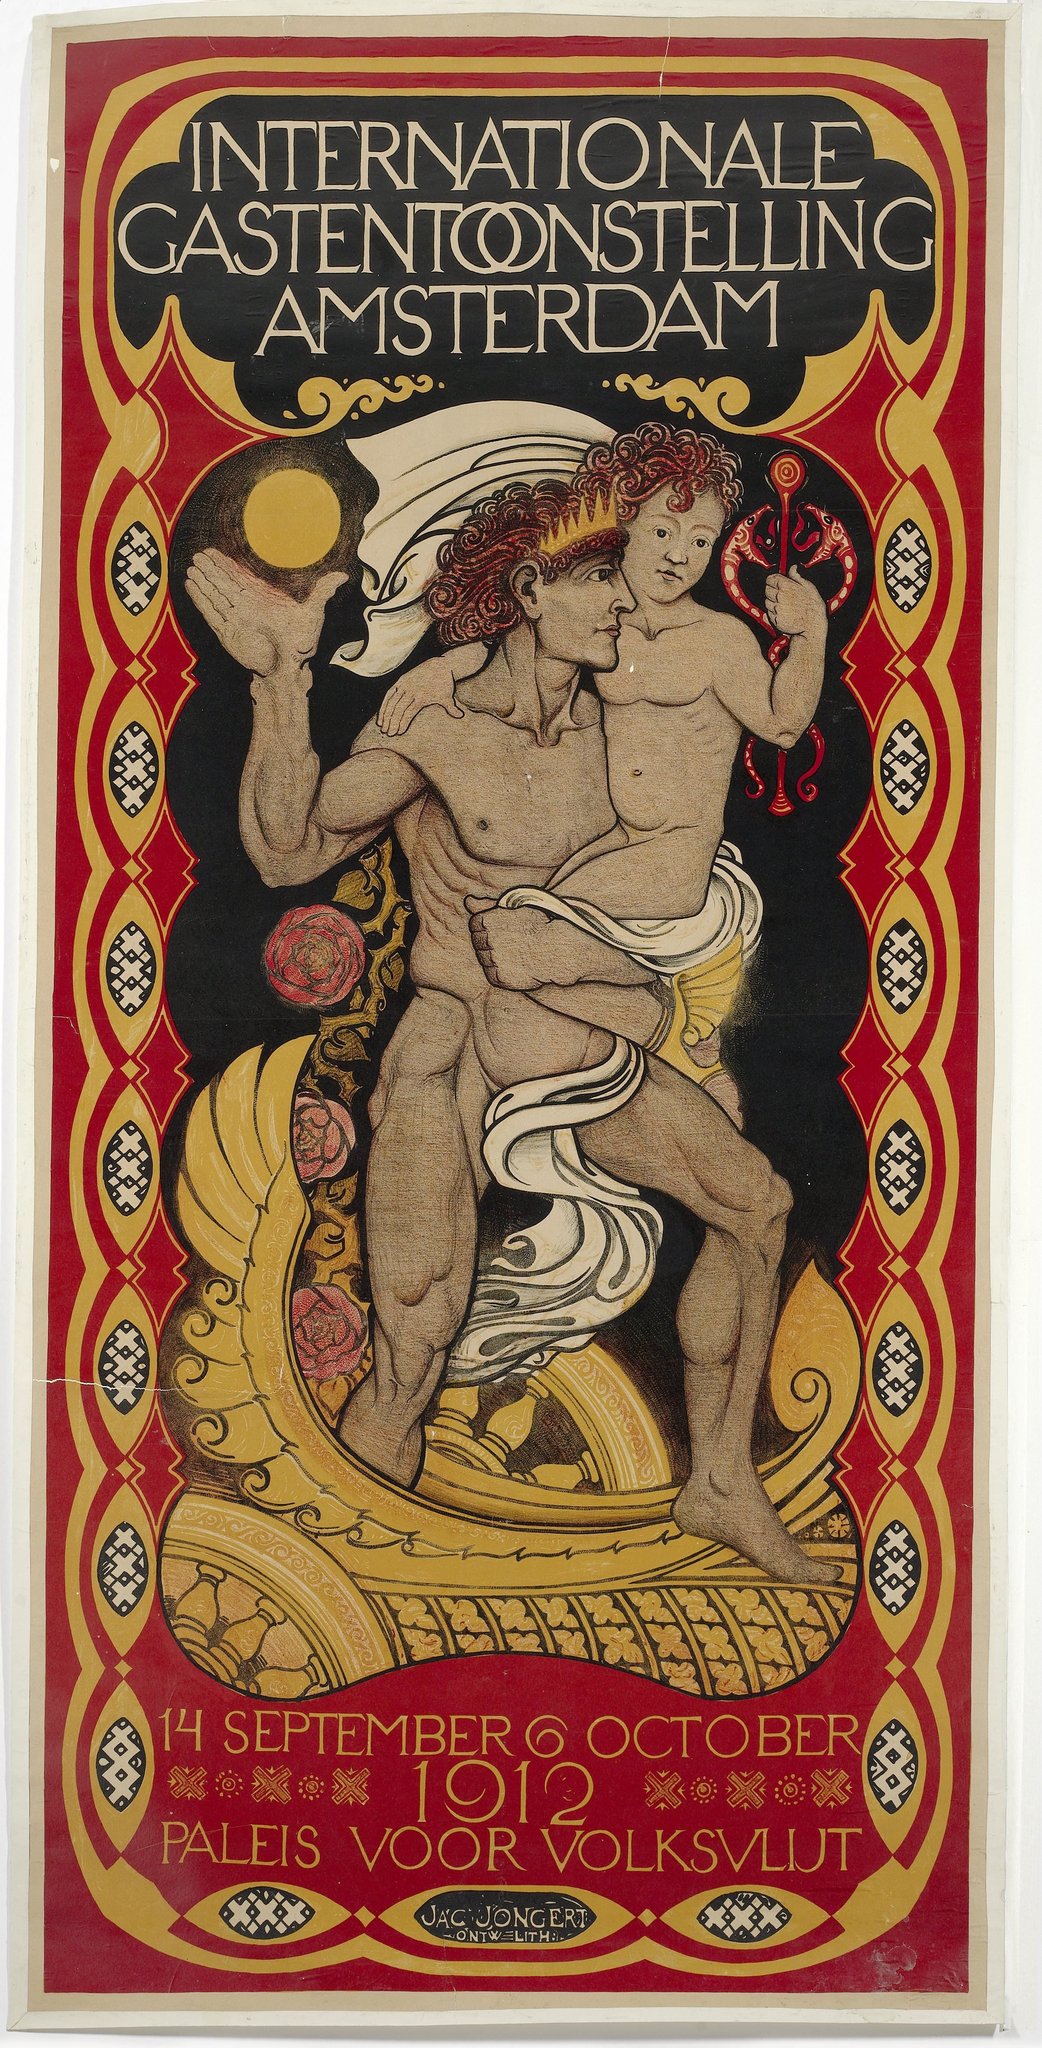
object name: poster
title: Internationale Gastentoonstelling in Amsterdam, 14 sept - 6 oct. 1912 in Paleis voor Volksvlijt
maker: jac jongert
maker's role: print maker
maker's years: 1883-1942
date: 1912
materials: paper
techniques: lithograph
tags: internationale gastentoonstelling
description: Affiche voor de Internationale Gastentoonstelling in het Paleis voor Volksvlijt op het Frederiksplein, 14 september-6 oktober 1912.